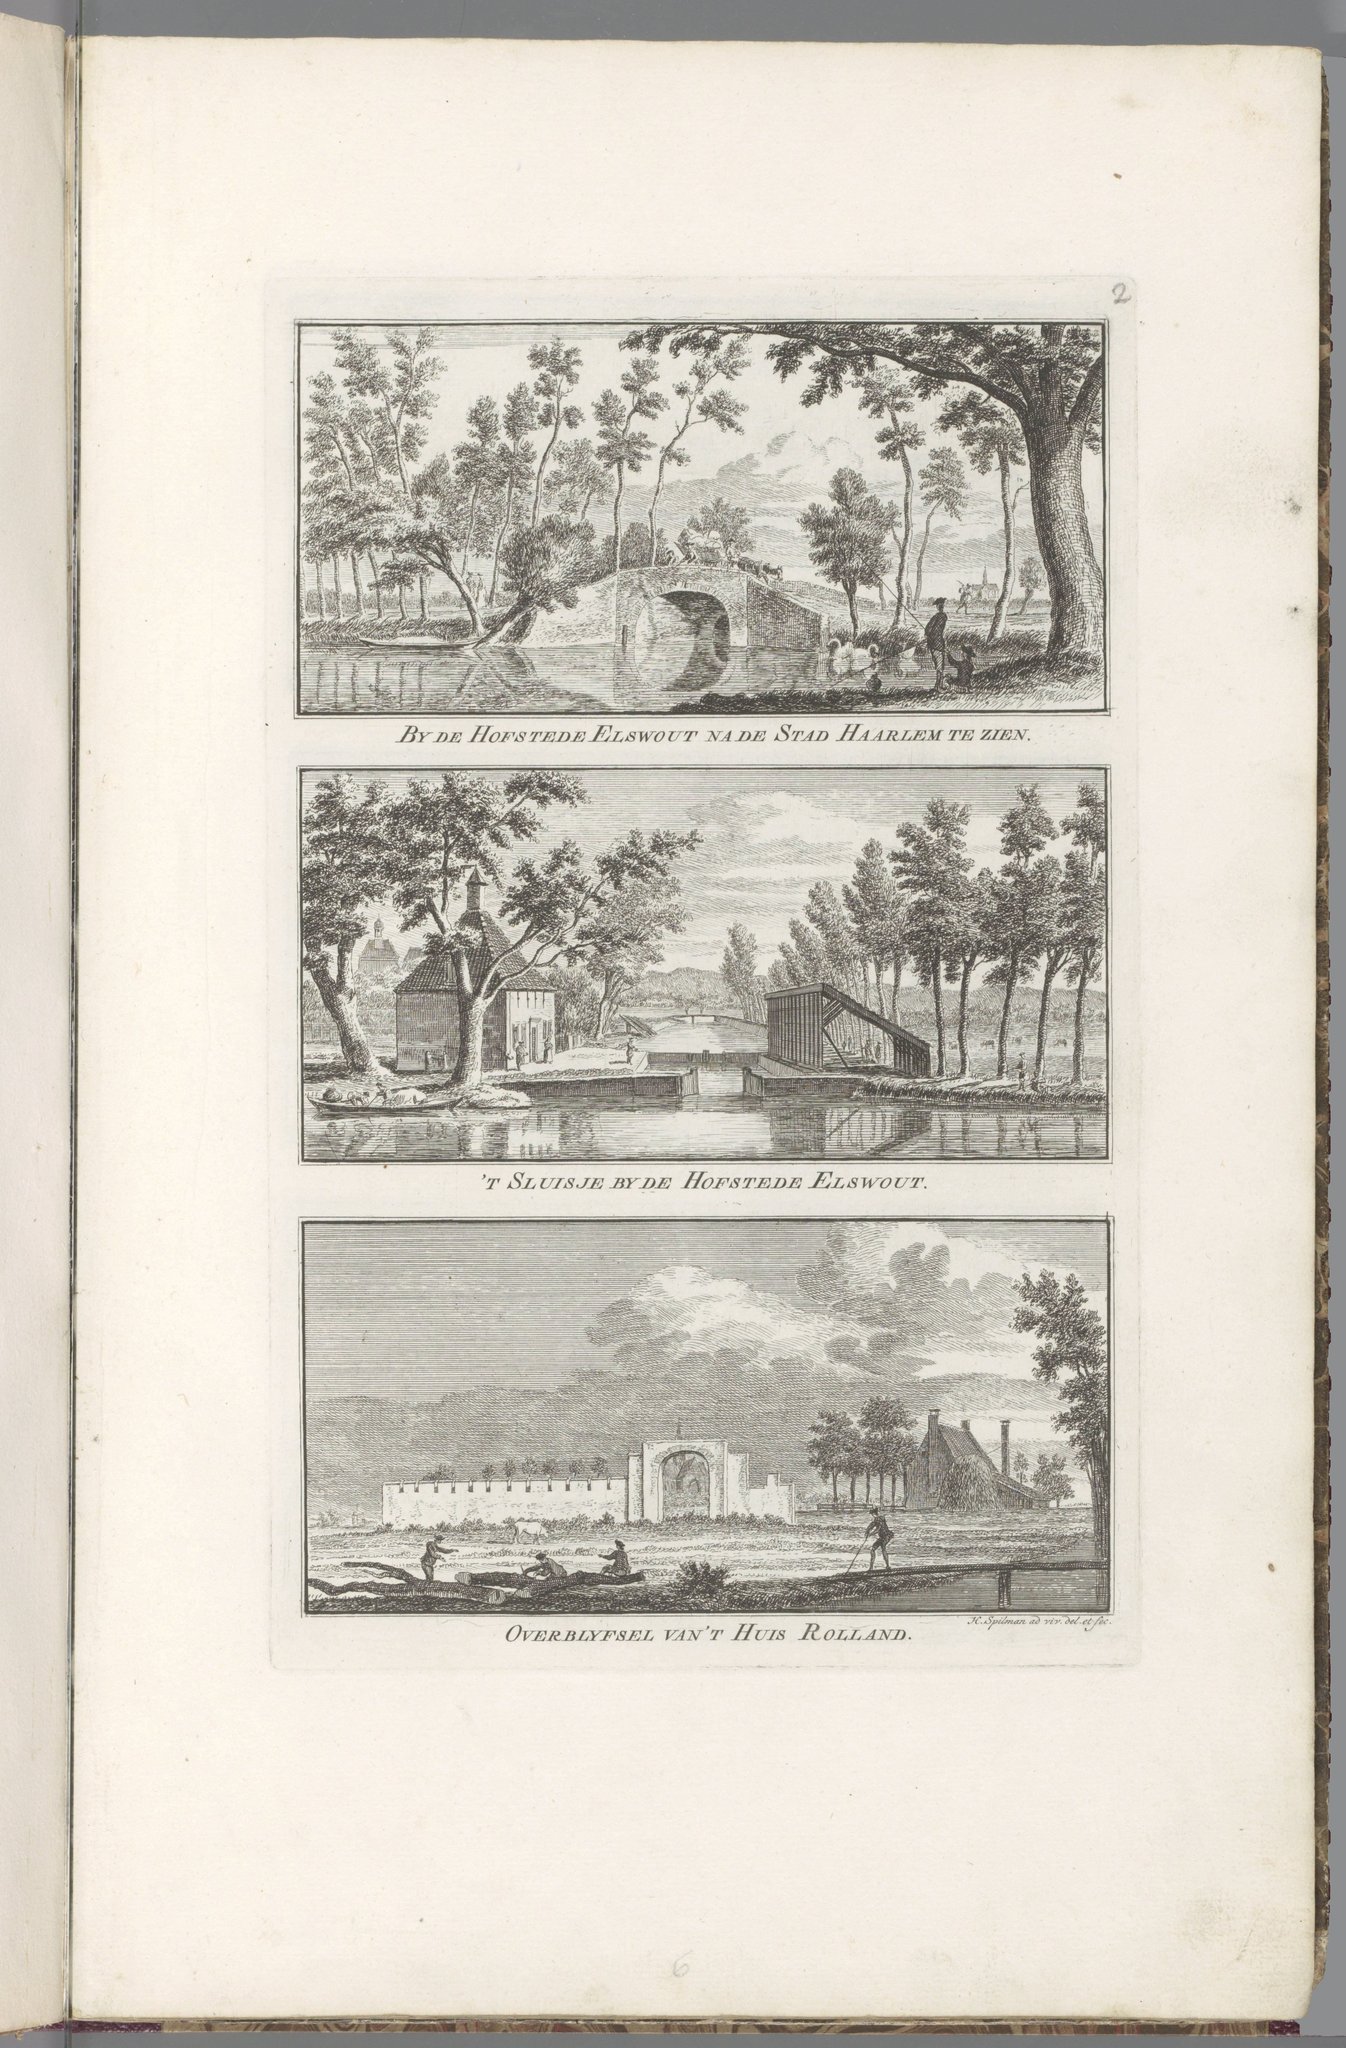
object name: print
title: Gezichten op de Hofstede Elswout en Huis Rolland te Overveen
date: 1761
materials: paper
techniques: etching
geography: haarlem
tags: landscapes in the temperate zone, open-air recreation, bridge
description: Drie voorstellingen. Boven: Gezicht op een brug bij de Hofstede Elswout en aan de horizon de stad Haarlem. Midden: Gezicht op de sluis bij de Hofstede Elswout in Overveen. Onder: Gezicht op de overblijfselen van Huis Rolland te Overveen. Deze prent maakt deel uit van een album.